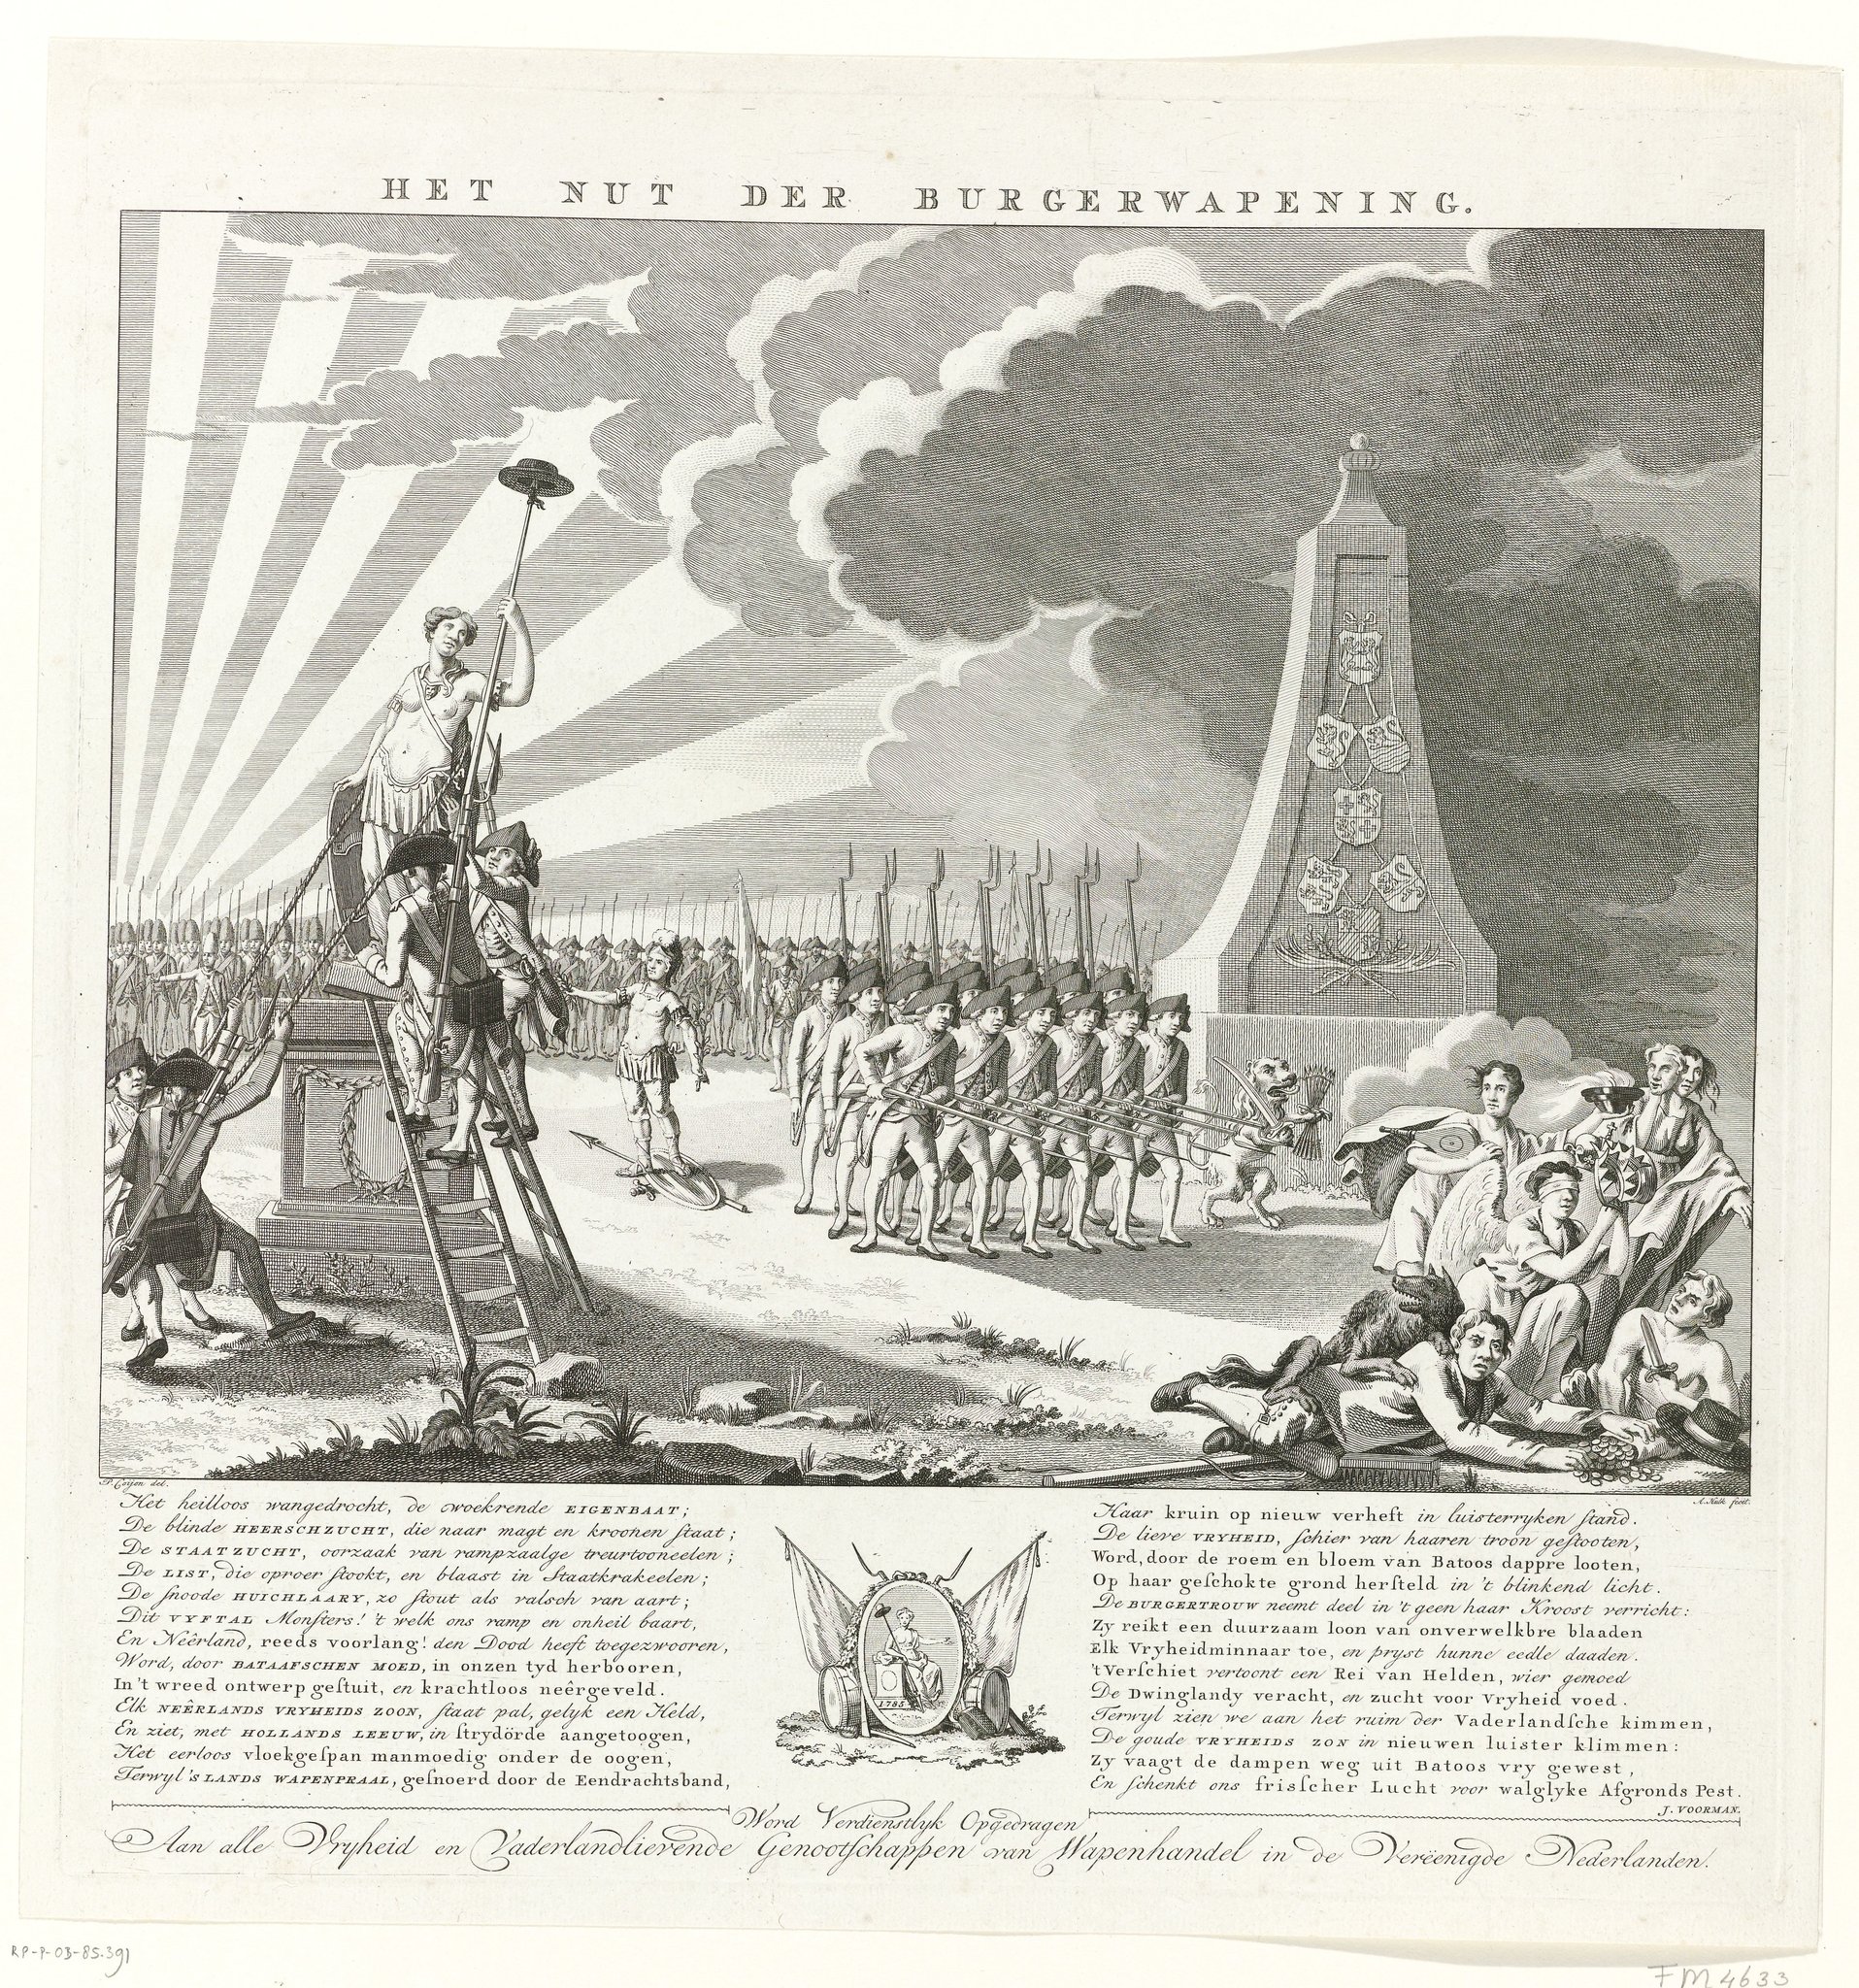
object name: print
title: Het Nut der Burgerwapening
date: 1785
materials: paper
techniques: engraving, etching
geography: northern netherlands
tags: warfare; military affairs (+ citizen soldiery, civil guard, citizen militia)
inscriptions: collector's mark: Lugt 2228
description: Allegorie op de burgerkorpsen die de vrijheid in Nederland bevorderen. Een vrijkorps verjaagt samen met de Nederlandse Leeuw bij een gedenkzuil met de wapens van de zeven provincies de Eigenbaat, Staatzucht, List en Huichelarij. Links wordt door soldaten een standbeeld van de Vrijheid opgericht. Links aan de hemel zonnestralen die de donkere wolken rechts verdrijven. Onderaan twee dertienreglige verzen in het Nederlands. Opgedragen aan alle Vrijheid en Vaderlandlievende Genootschappen van Wapenhandel in de Verenigde Nederlanden.